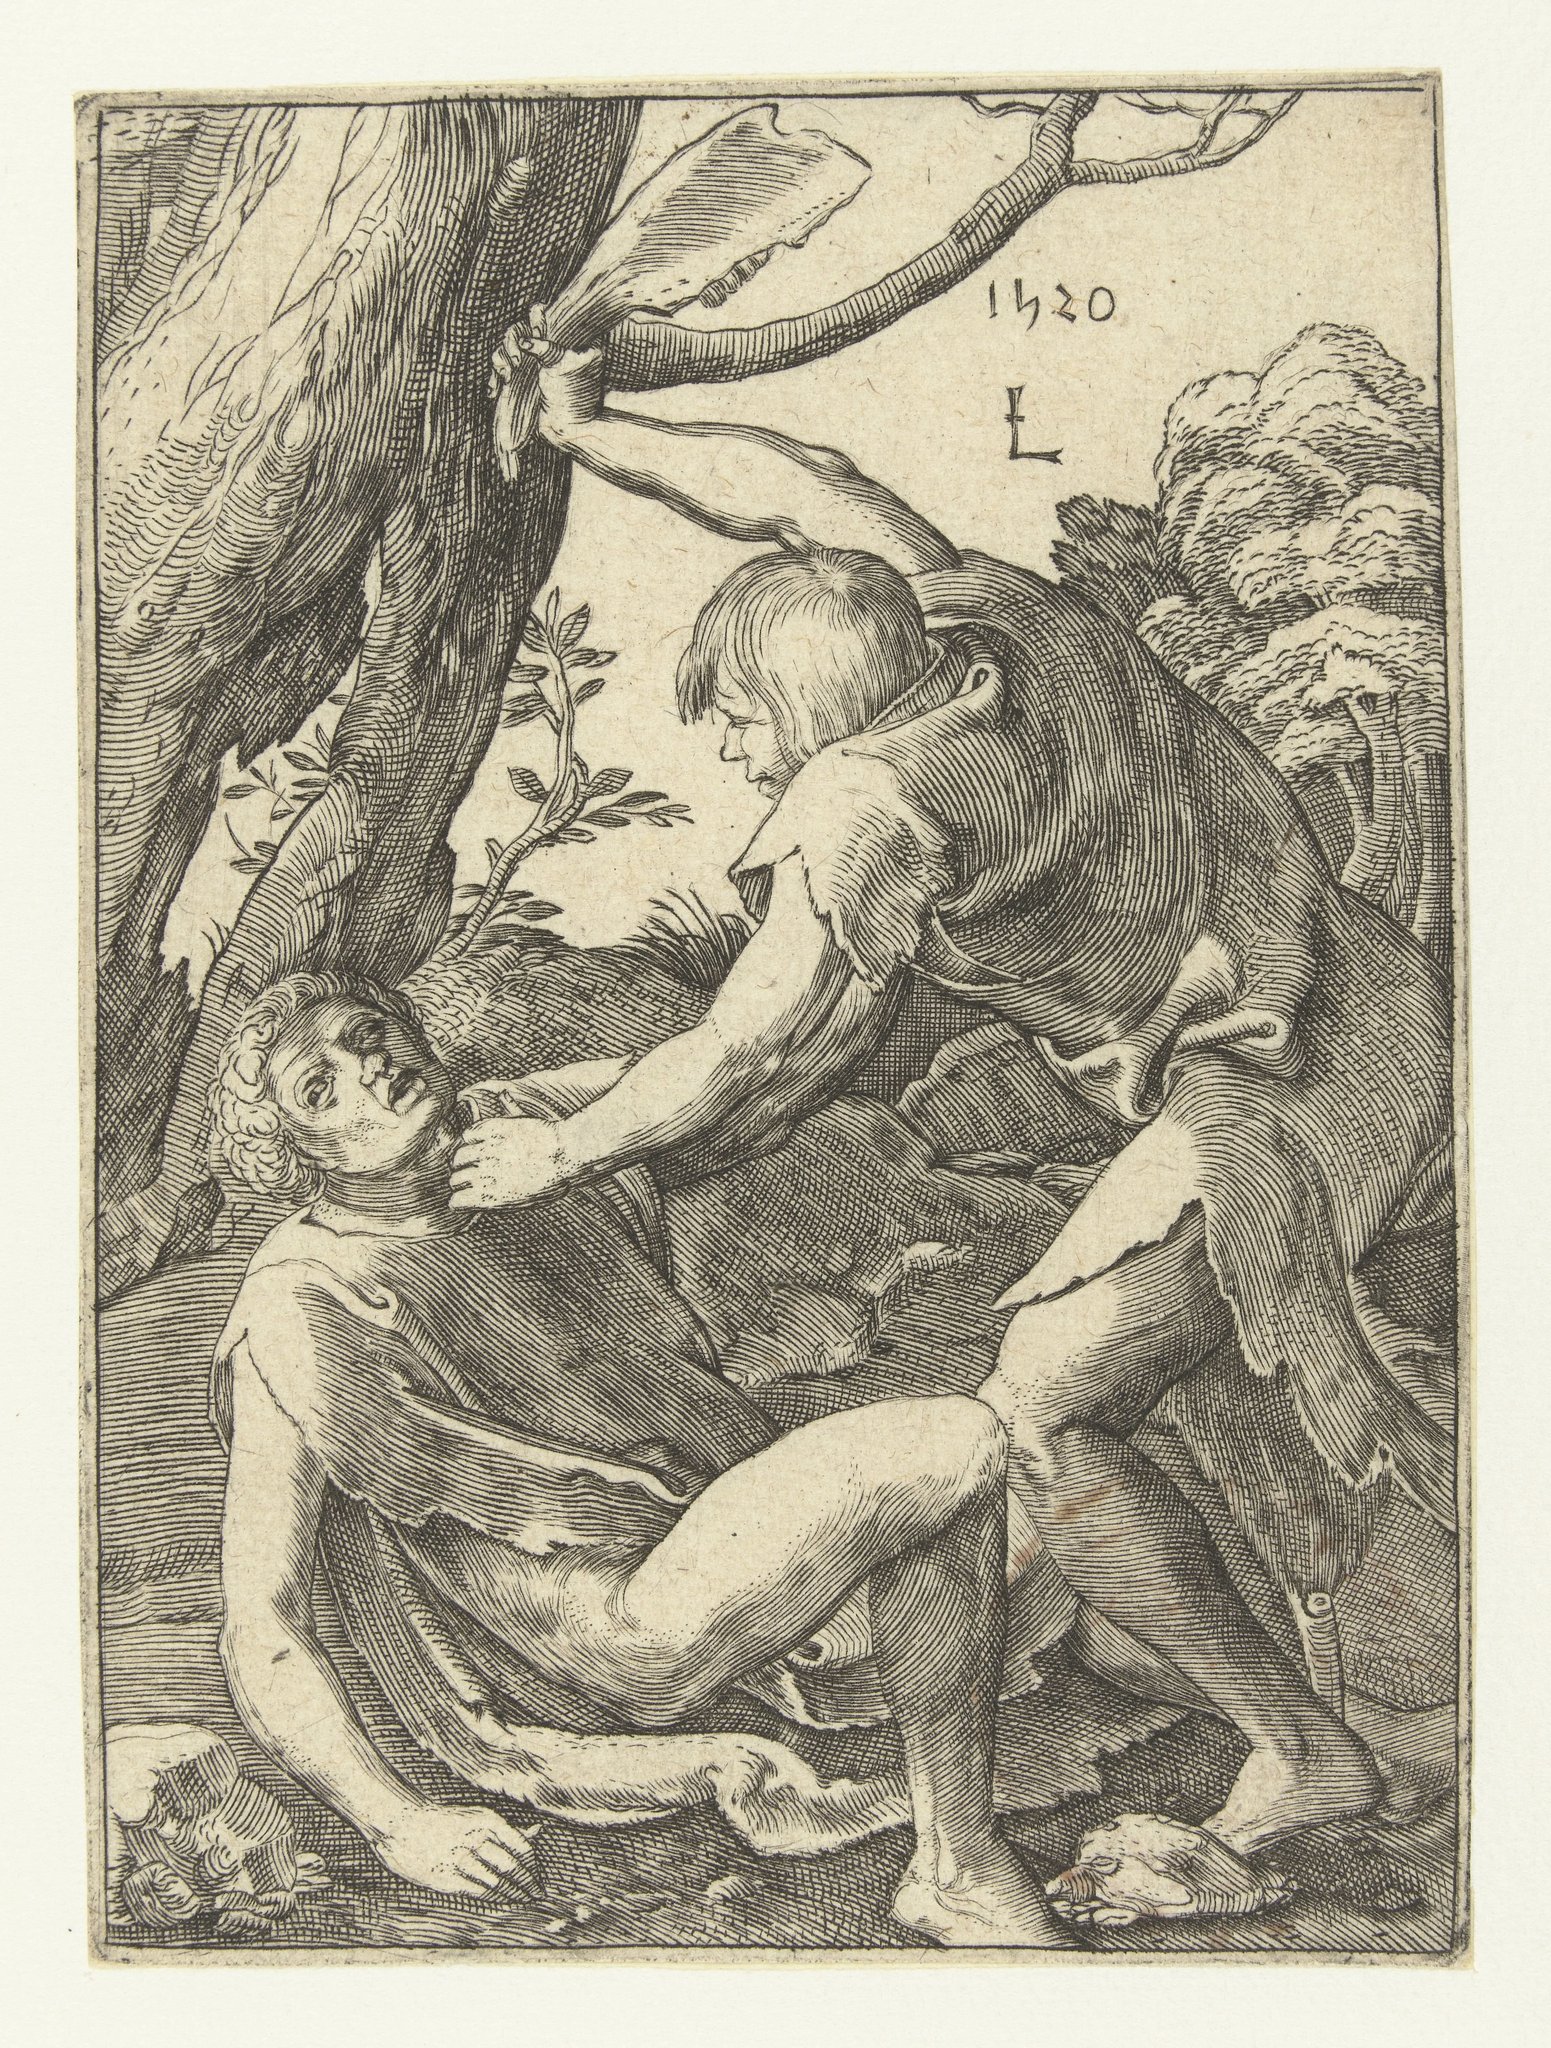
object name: print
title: Kaïn doodt Abel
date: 1520-1583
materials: paper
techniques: engraving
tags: the killing of abel: cain slays him with a stone, a club or a jaw-bone, alternatively with a spade or another tool as weapon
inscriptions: collector's mark: Lugt 240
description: Kaïn met opgeheven stuk kaakbot, Abel op de grond geduwd.